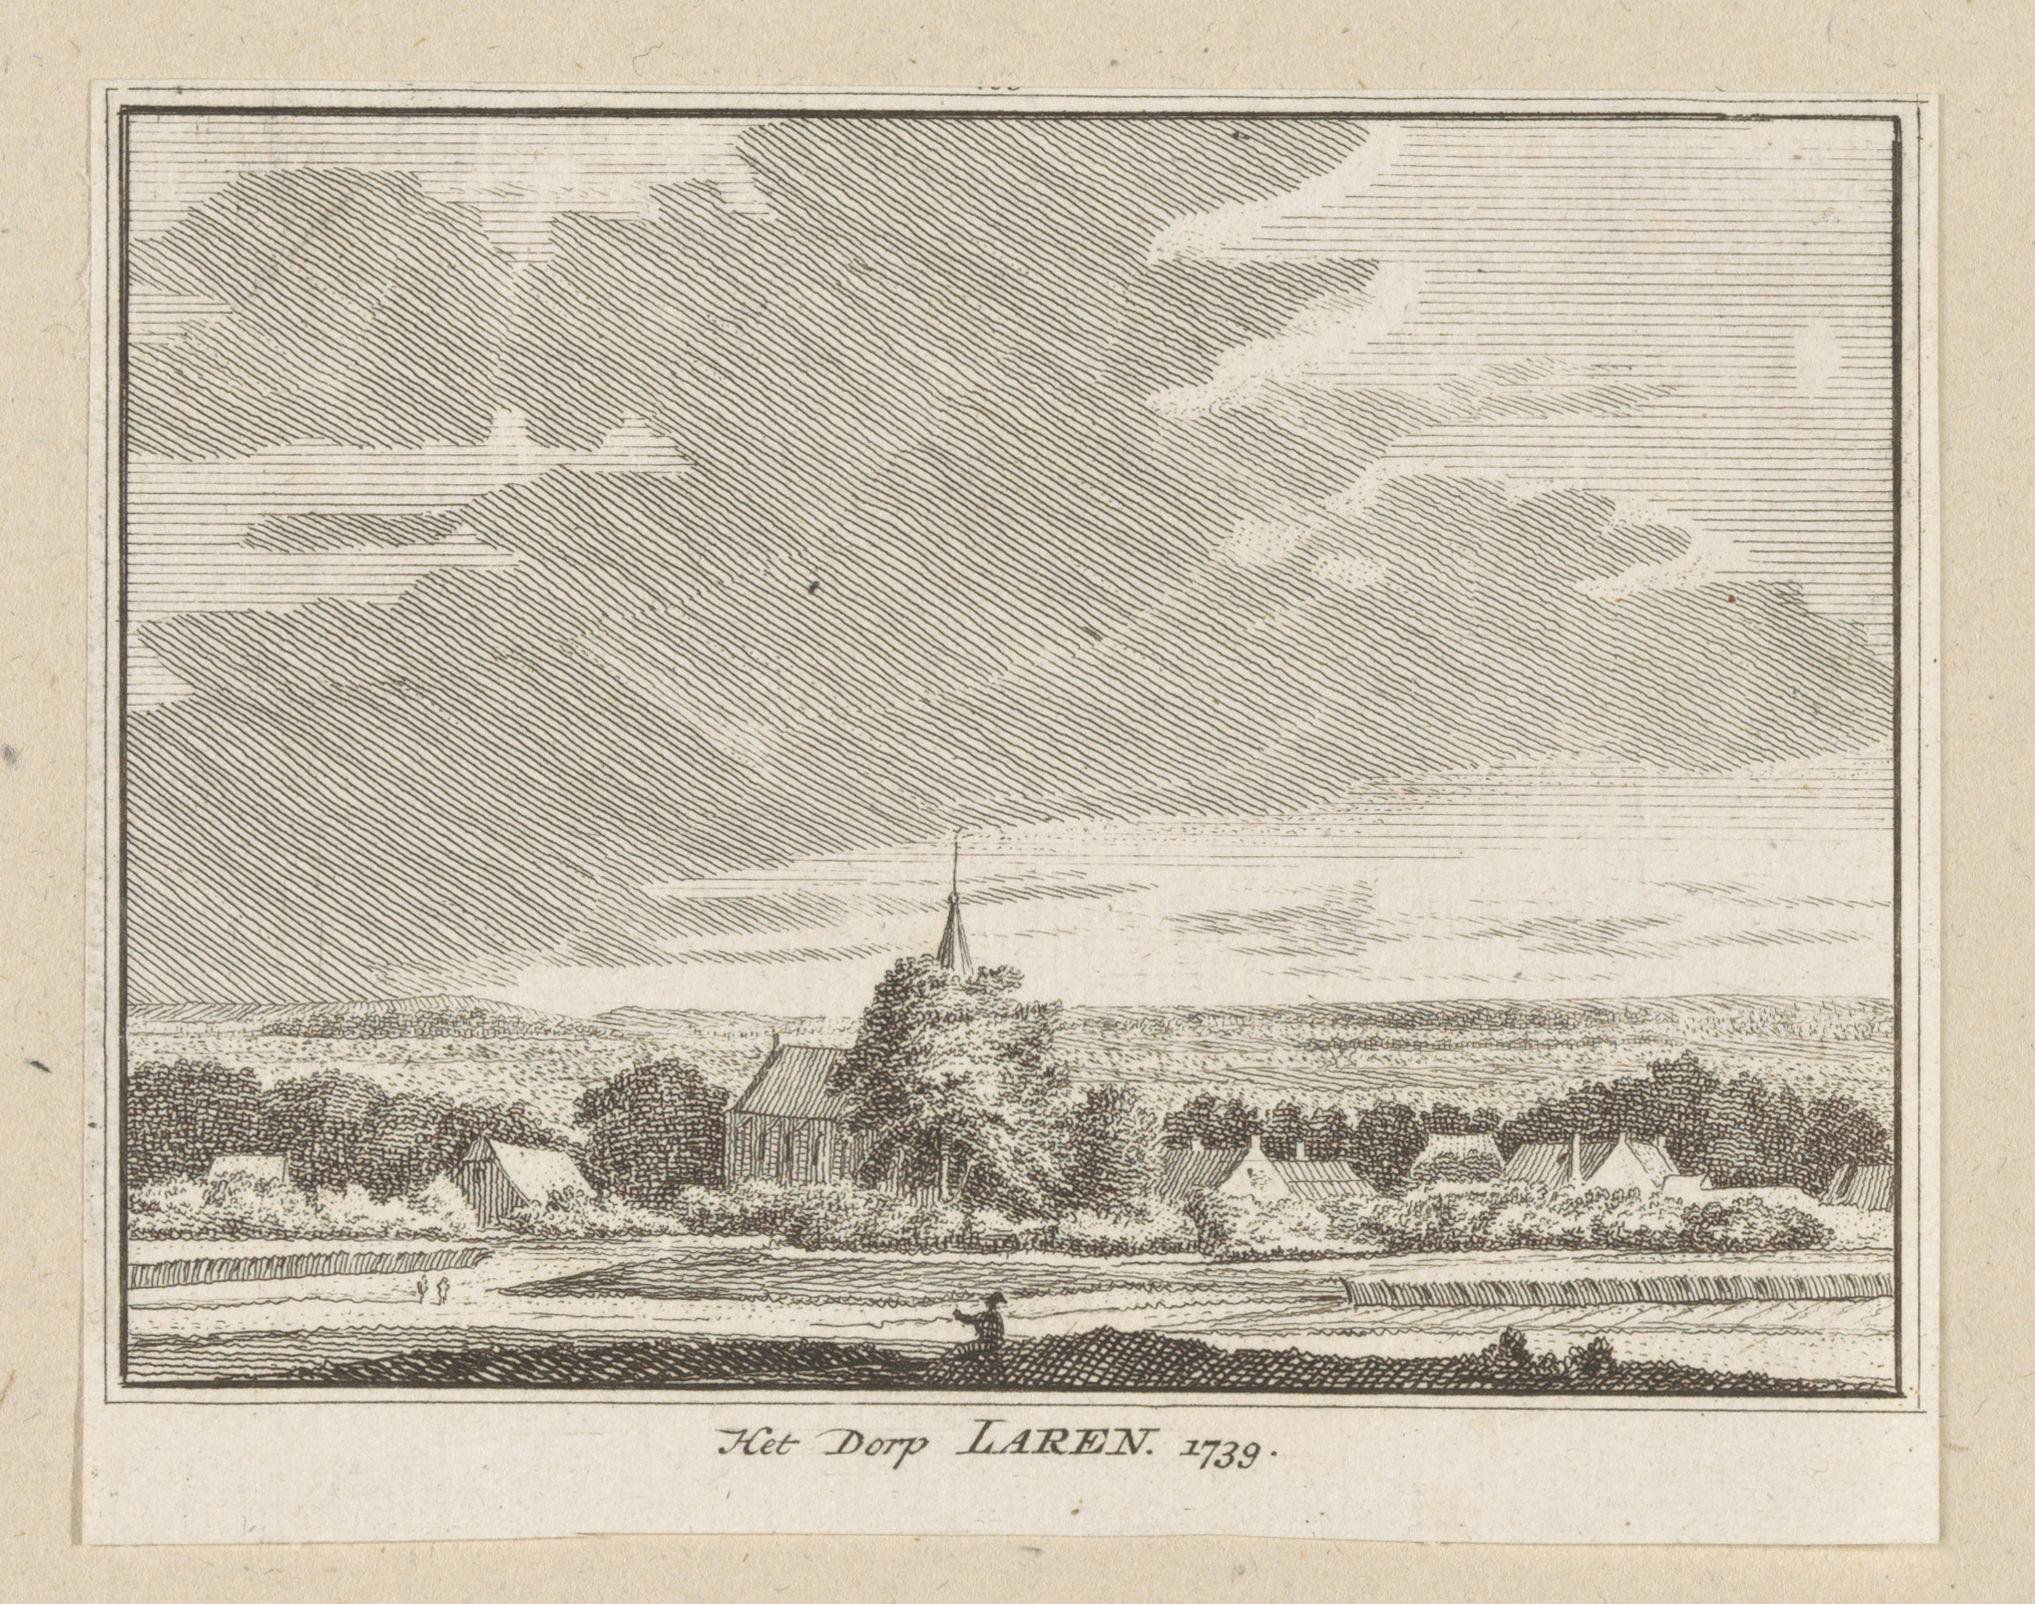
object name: print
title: Gezicht op Laren, 1739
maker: hendrik spilman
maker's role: draughtsman, painter, print maker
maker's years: 1721-1784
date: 1757-1792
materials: paper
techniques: engraving, etching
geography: haarlem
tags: prospect of village, silhouette of village, church (exterior)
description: Prent ook gebruikt in: Het verheerlykt Nederland of kabinet van hedendaagsche gezigten van steden, dorpen (…). 9 delen. Amsterdam: Isaak Tirion en weduwe Isaak Tirion, 1745-1774, dl. 6 (1757), ill. 433. Of in: Nederlandsche tafereelen; of eene keurige verzameling van negen honderd fraaije gezigten van steden, dorpen, sloten, oudheden (….). 9 delen. Amsterdam: Jan de Groot, 1792, dl. 6, ill. 433. Uit welke druk het huidige exemplaar precies komt is niet na te gaan.